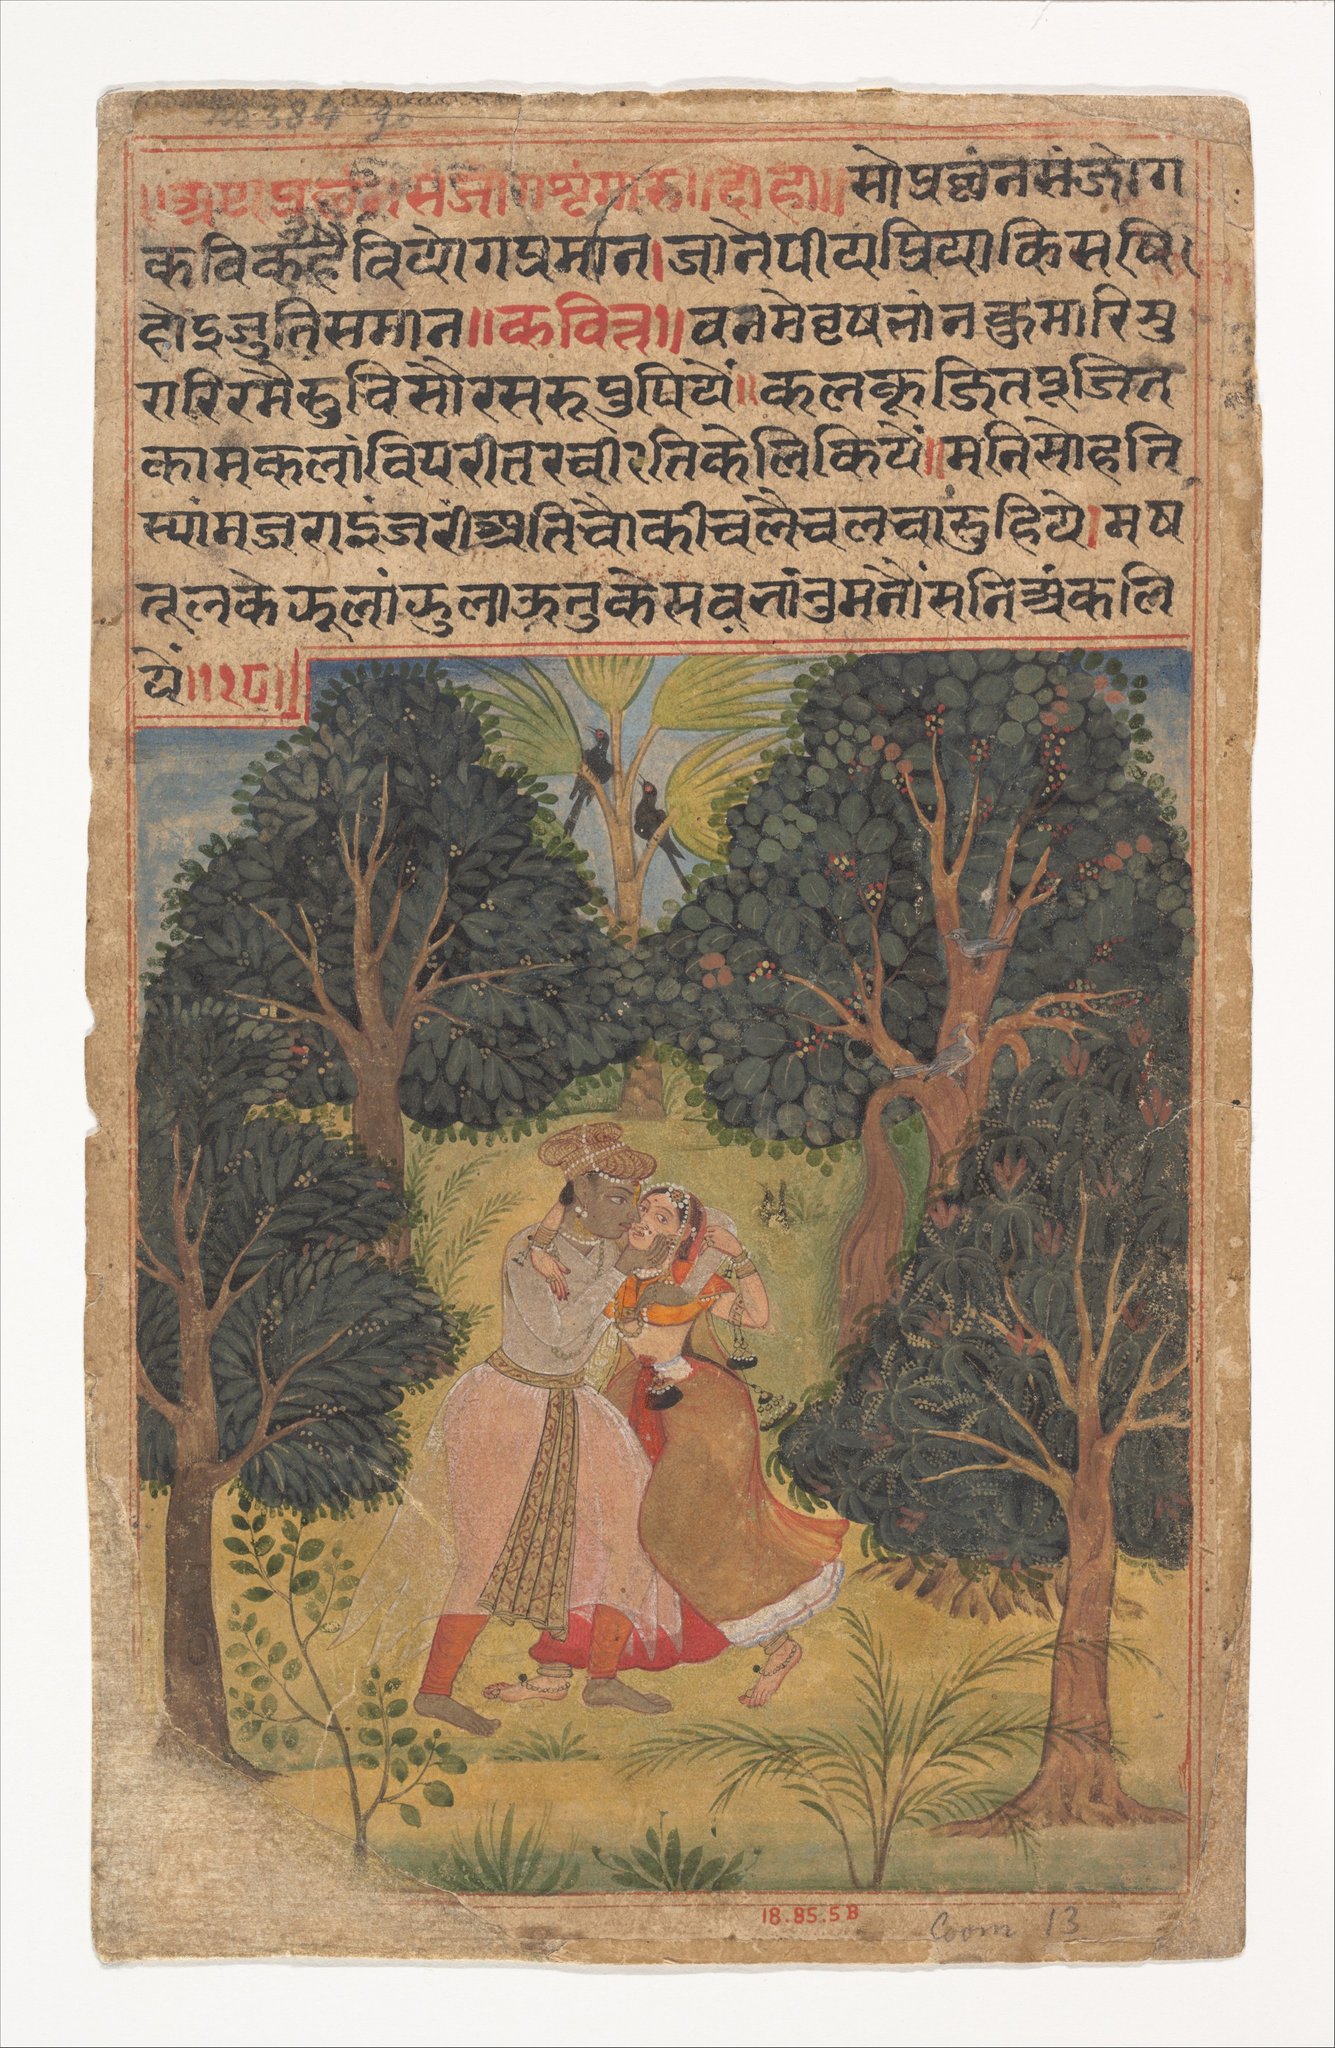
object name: folio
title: Krishna Woos Radha: Page from the Dispersed "Boston" Rasikapriya (Lover's Breviary)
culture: indian or rajasthan or amber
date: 1610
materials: gold, ink, paper, watercolor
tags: birds,trees,krishna,radha